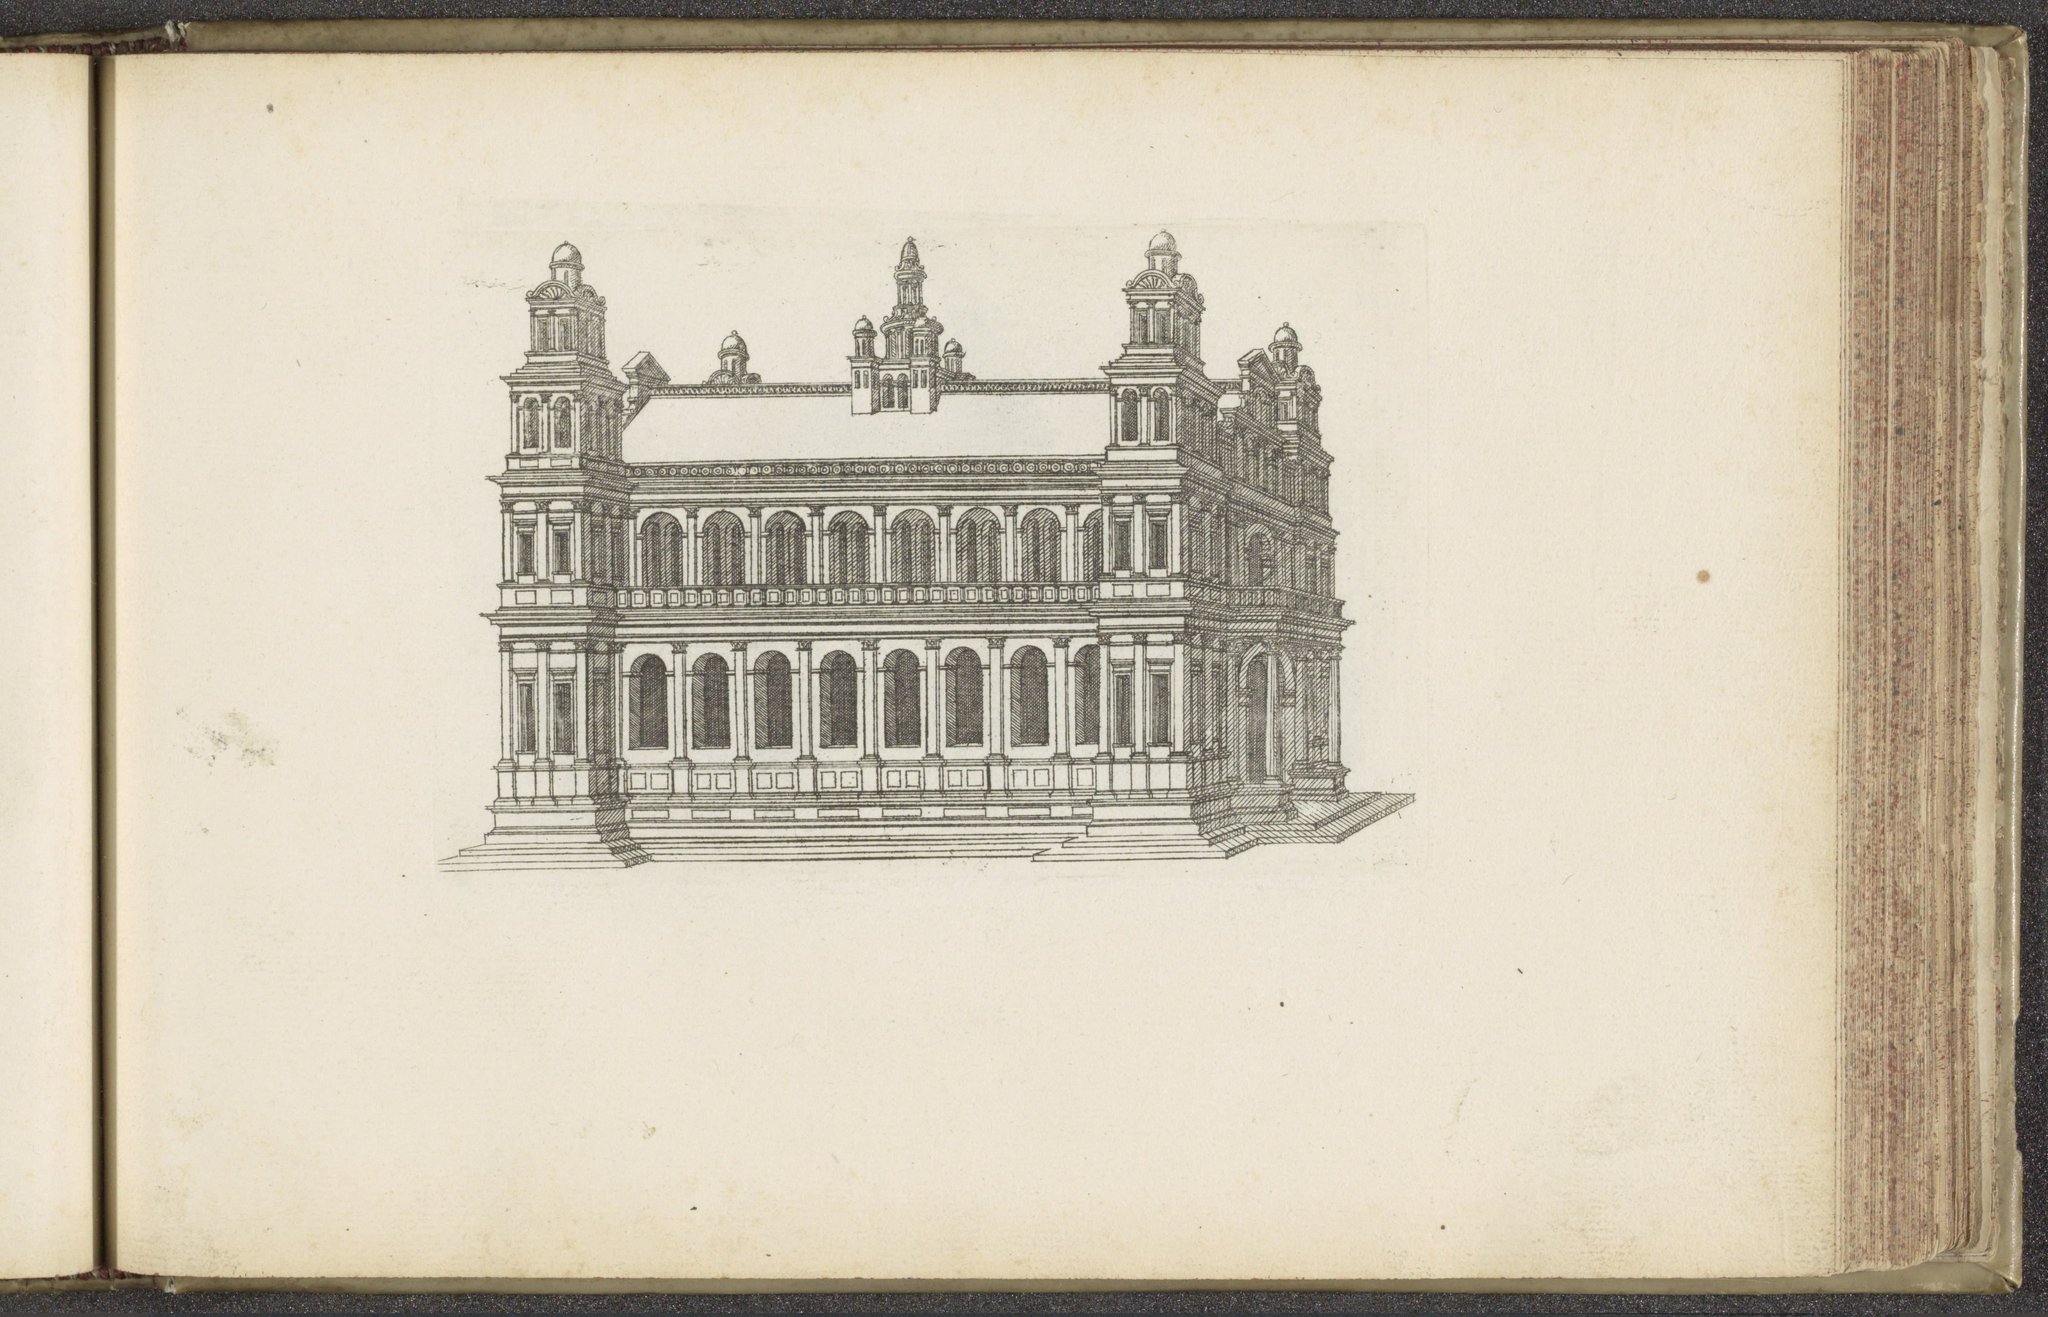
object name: print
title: Langwerpig kerkgebouw met op de hoeken torens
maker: jacques androuet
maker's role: draughtsman, print maker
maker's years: 1515-1584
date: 1550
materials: paper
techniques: etching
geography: orléans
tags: church (exterior), exterior ~ representation of a building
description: Langwerpig kerkgebouw met op de hoeken torens. Deze prent maakt deel uit van een album.